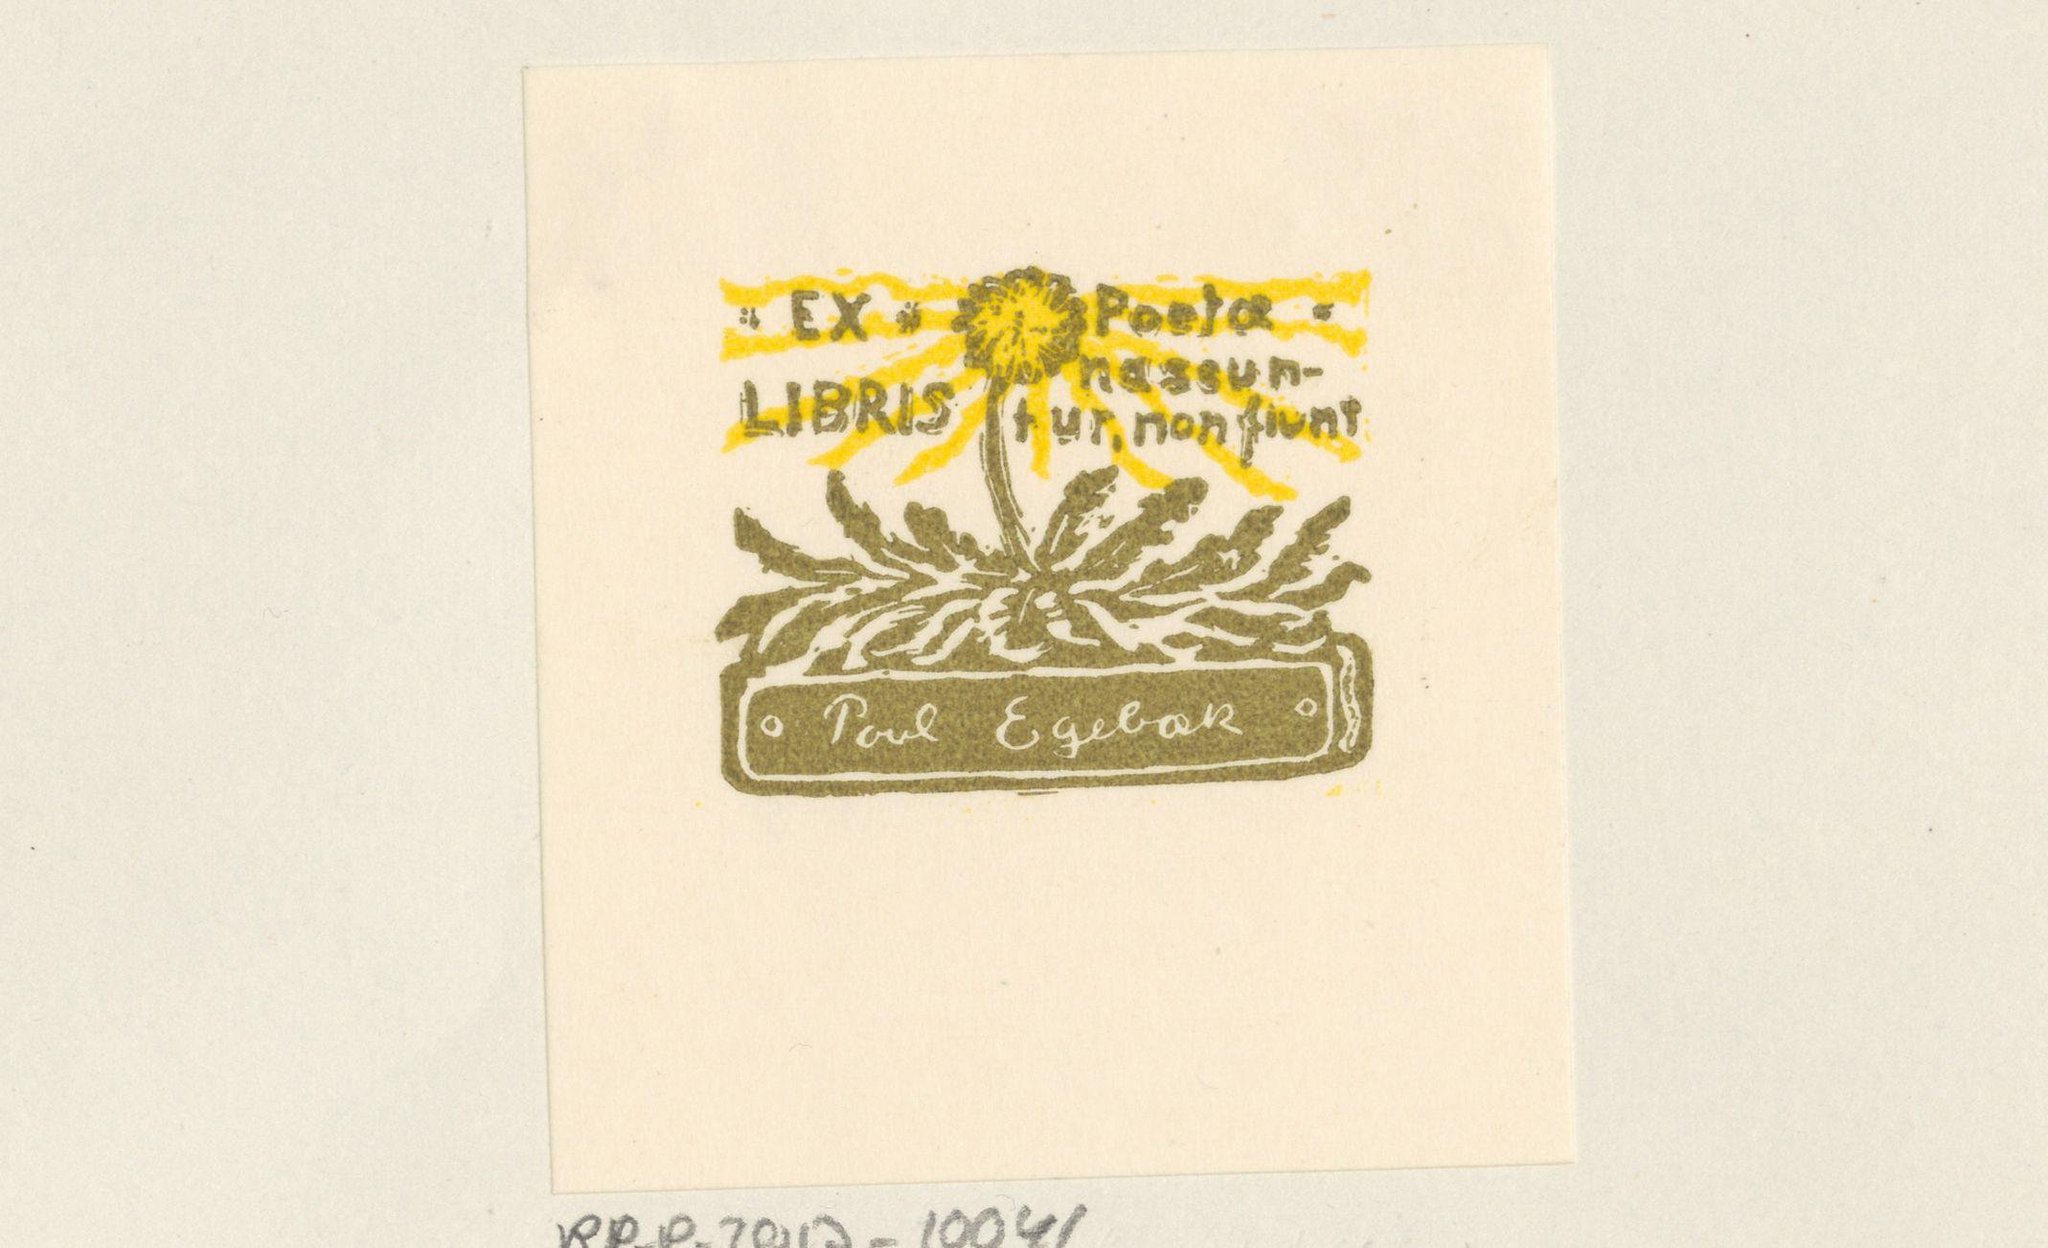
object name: bookplate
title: Poetae nassun-tur, non fiunt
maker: poul egebæk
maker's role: print maker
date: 1953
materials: paper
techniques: linocut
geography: rudkøbing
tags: print maker, poul egebæk, flowers: dandelion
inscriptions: workshop stamp: ‘Poul Egebæk/ Rudkøbing/ Denmark’